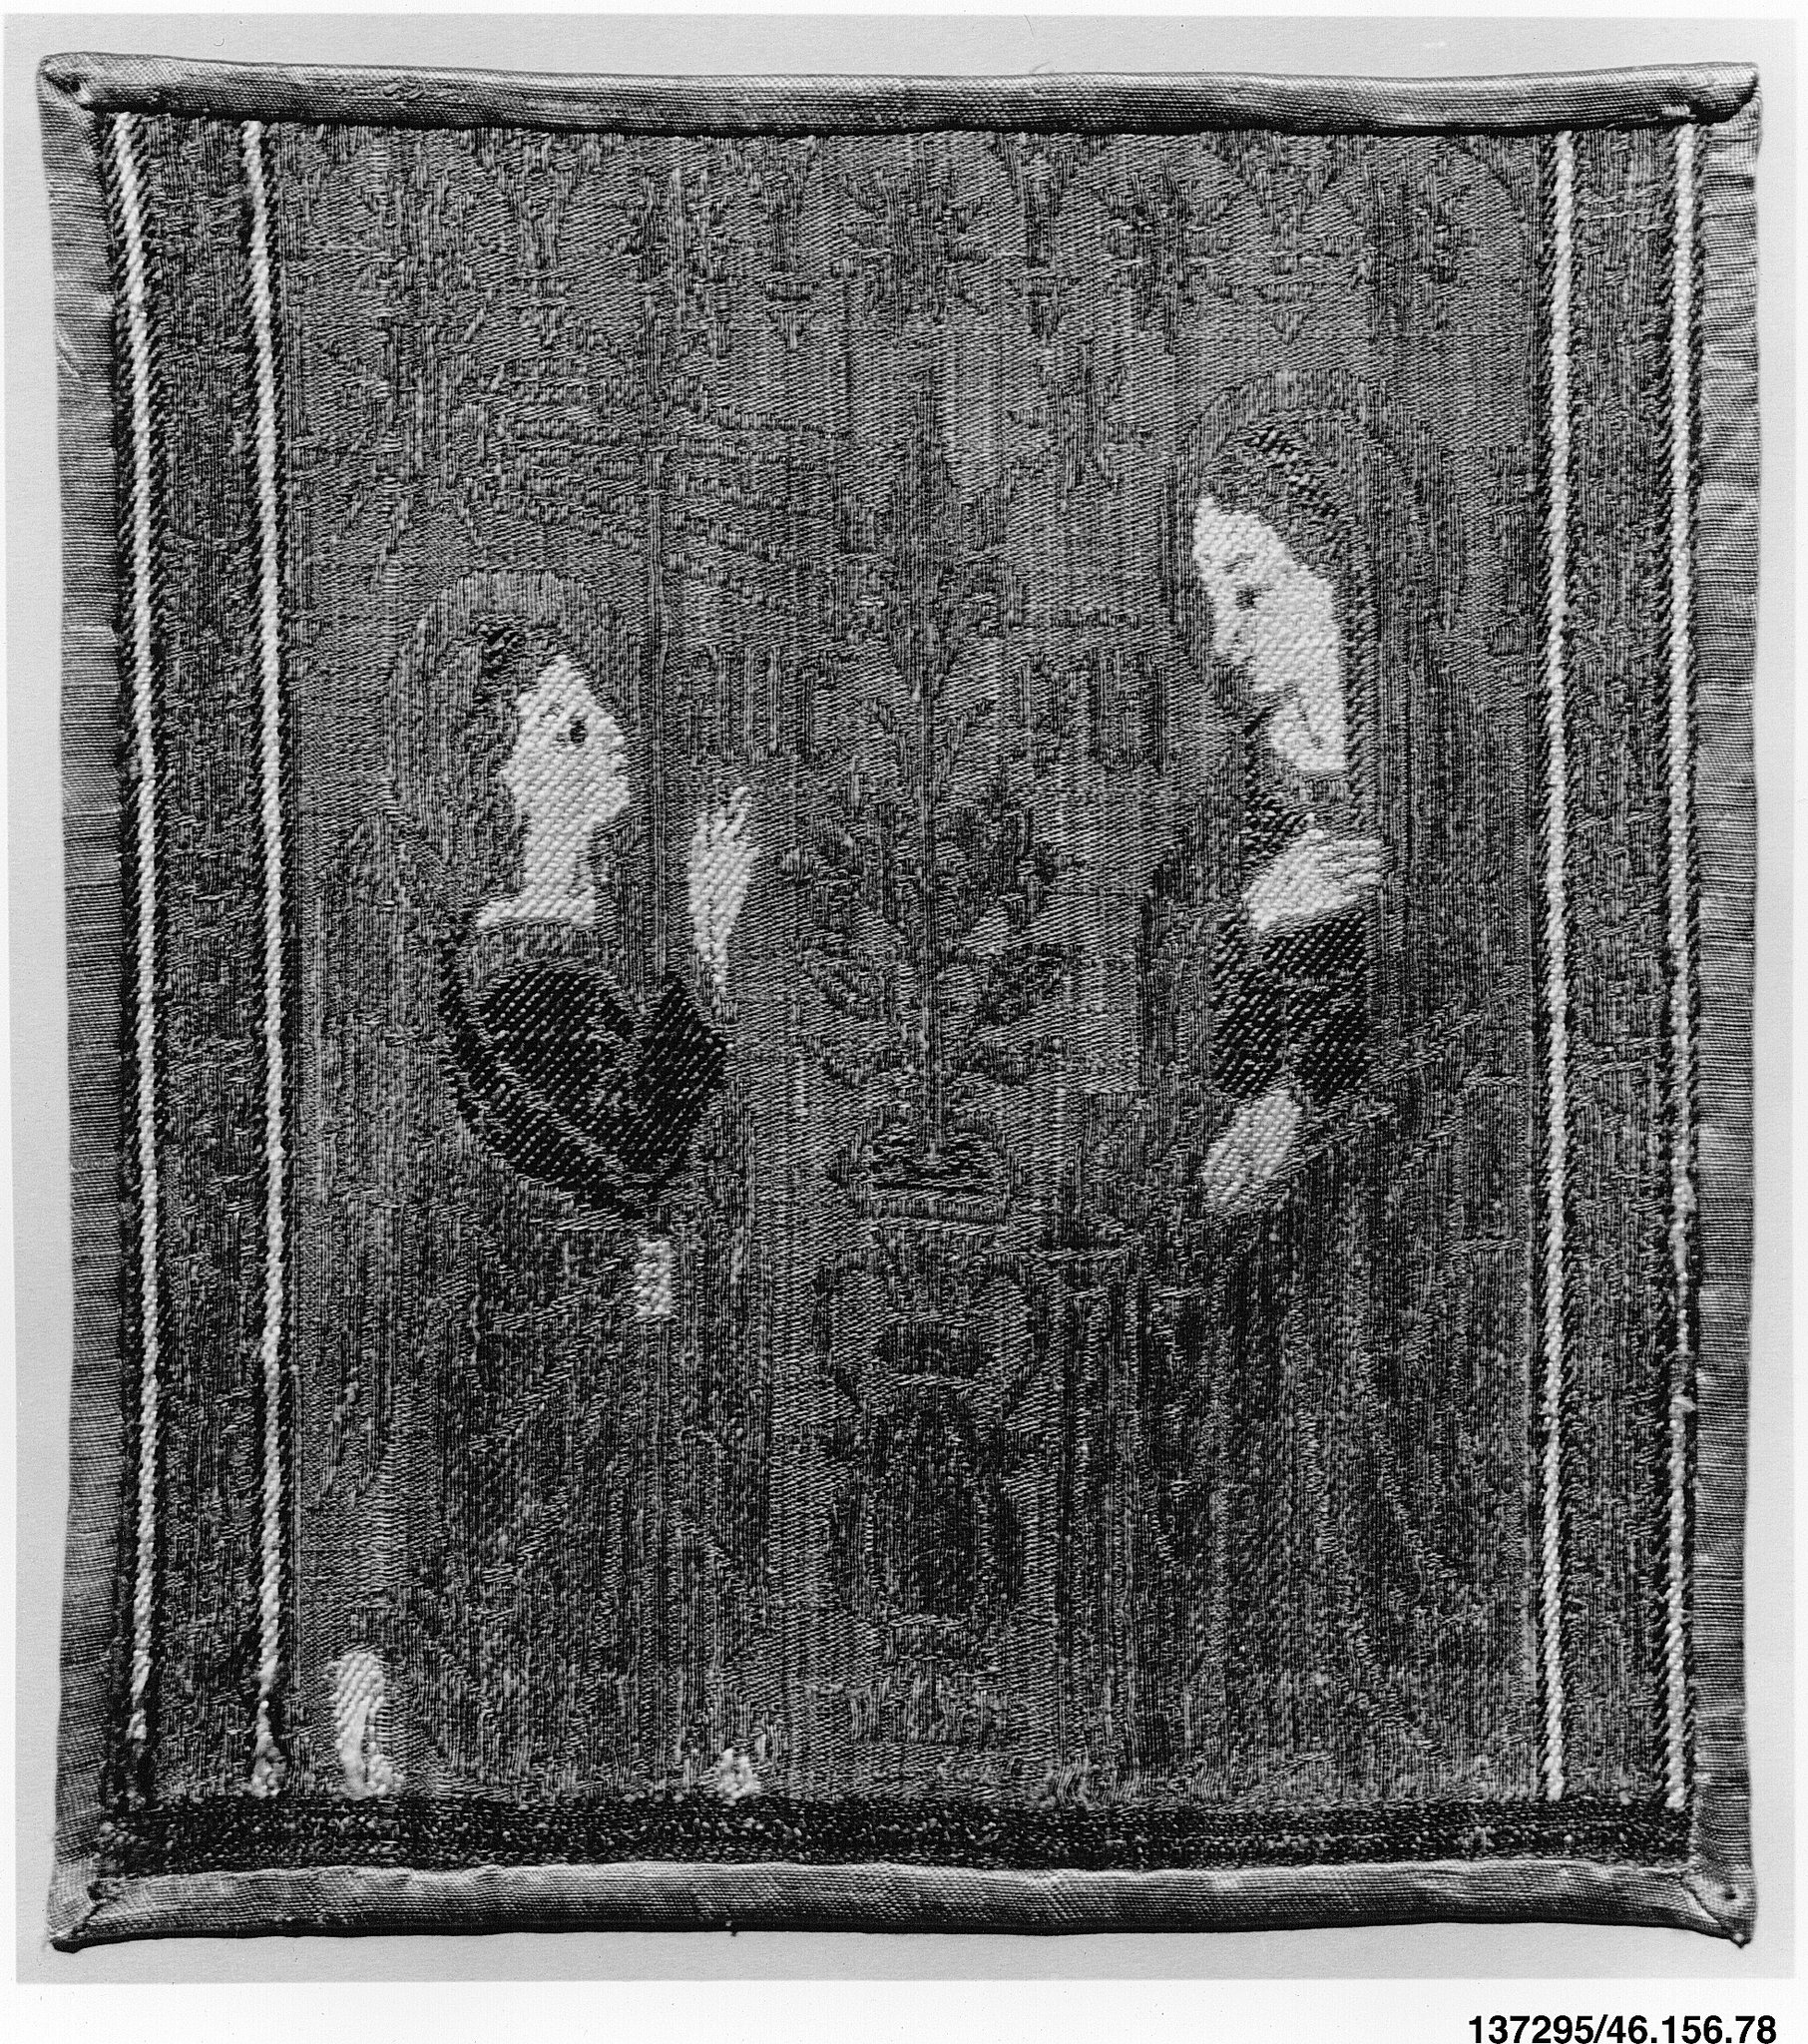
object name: orphrey fragment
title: Part of an orphrey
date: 1401-1450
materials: metal thread, silk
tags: annunciation